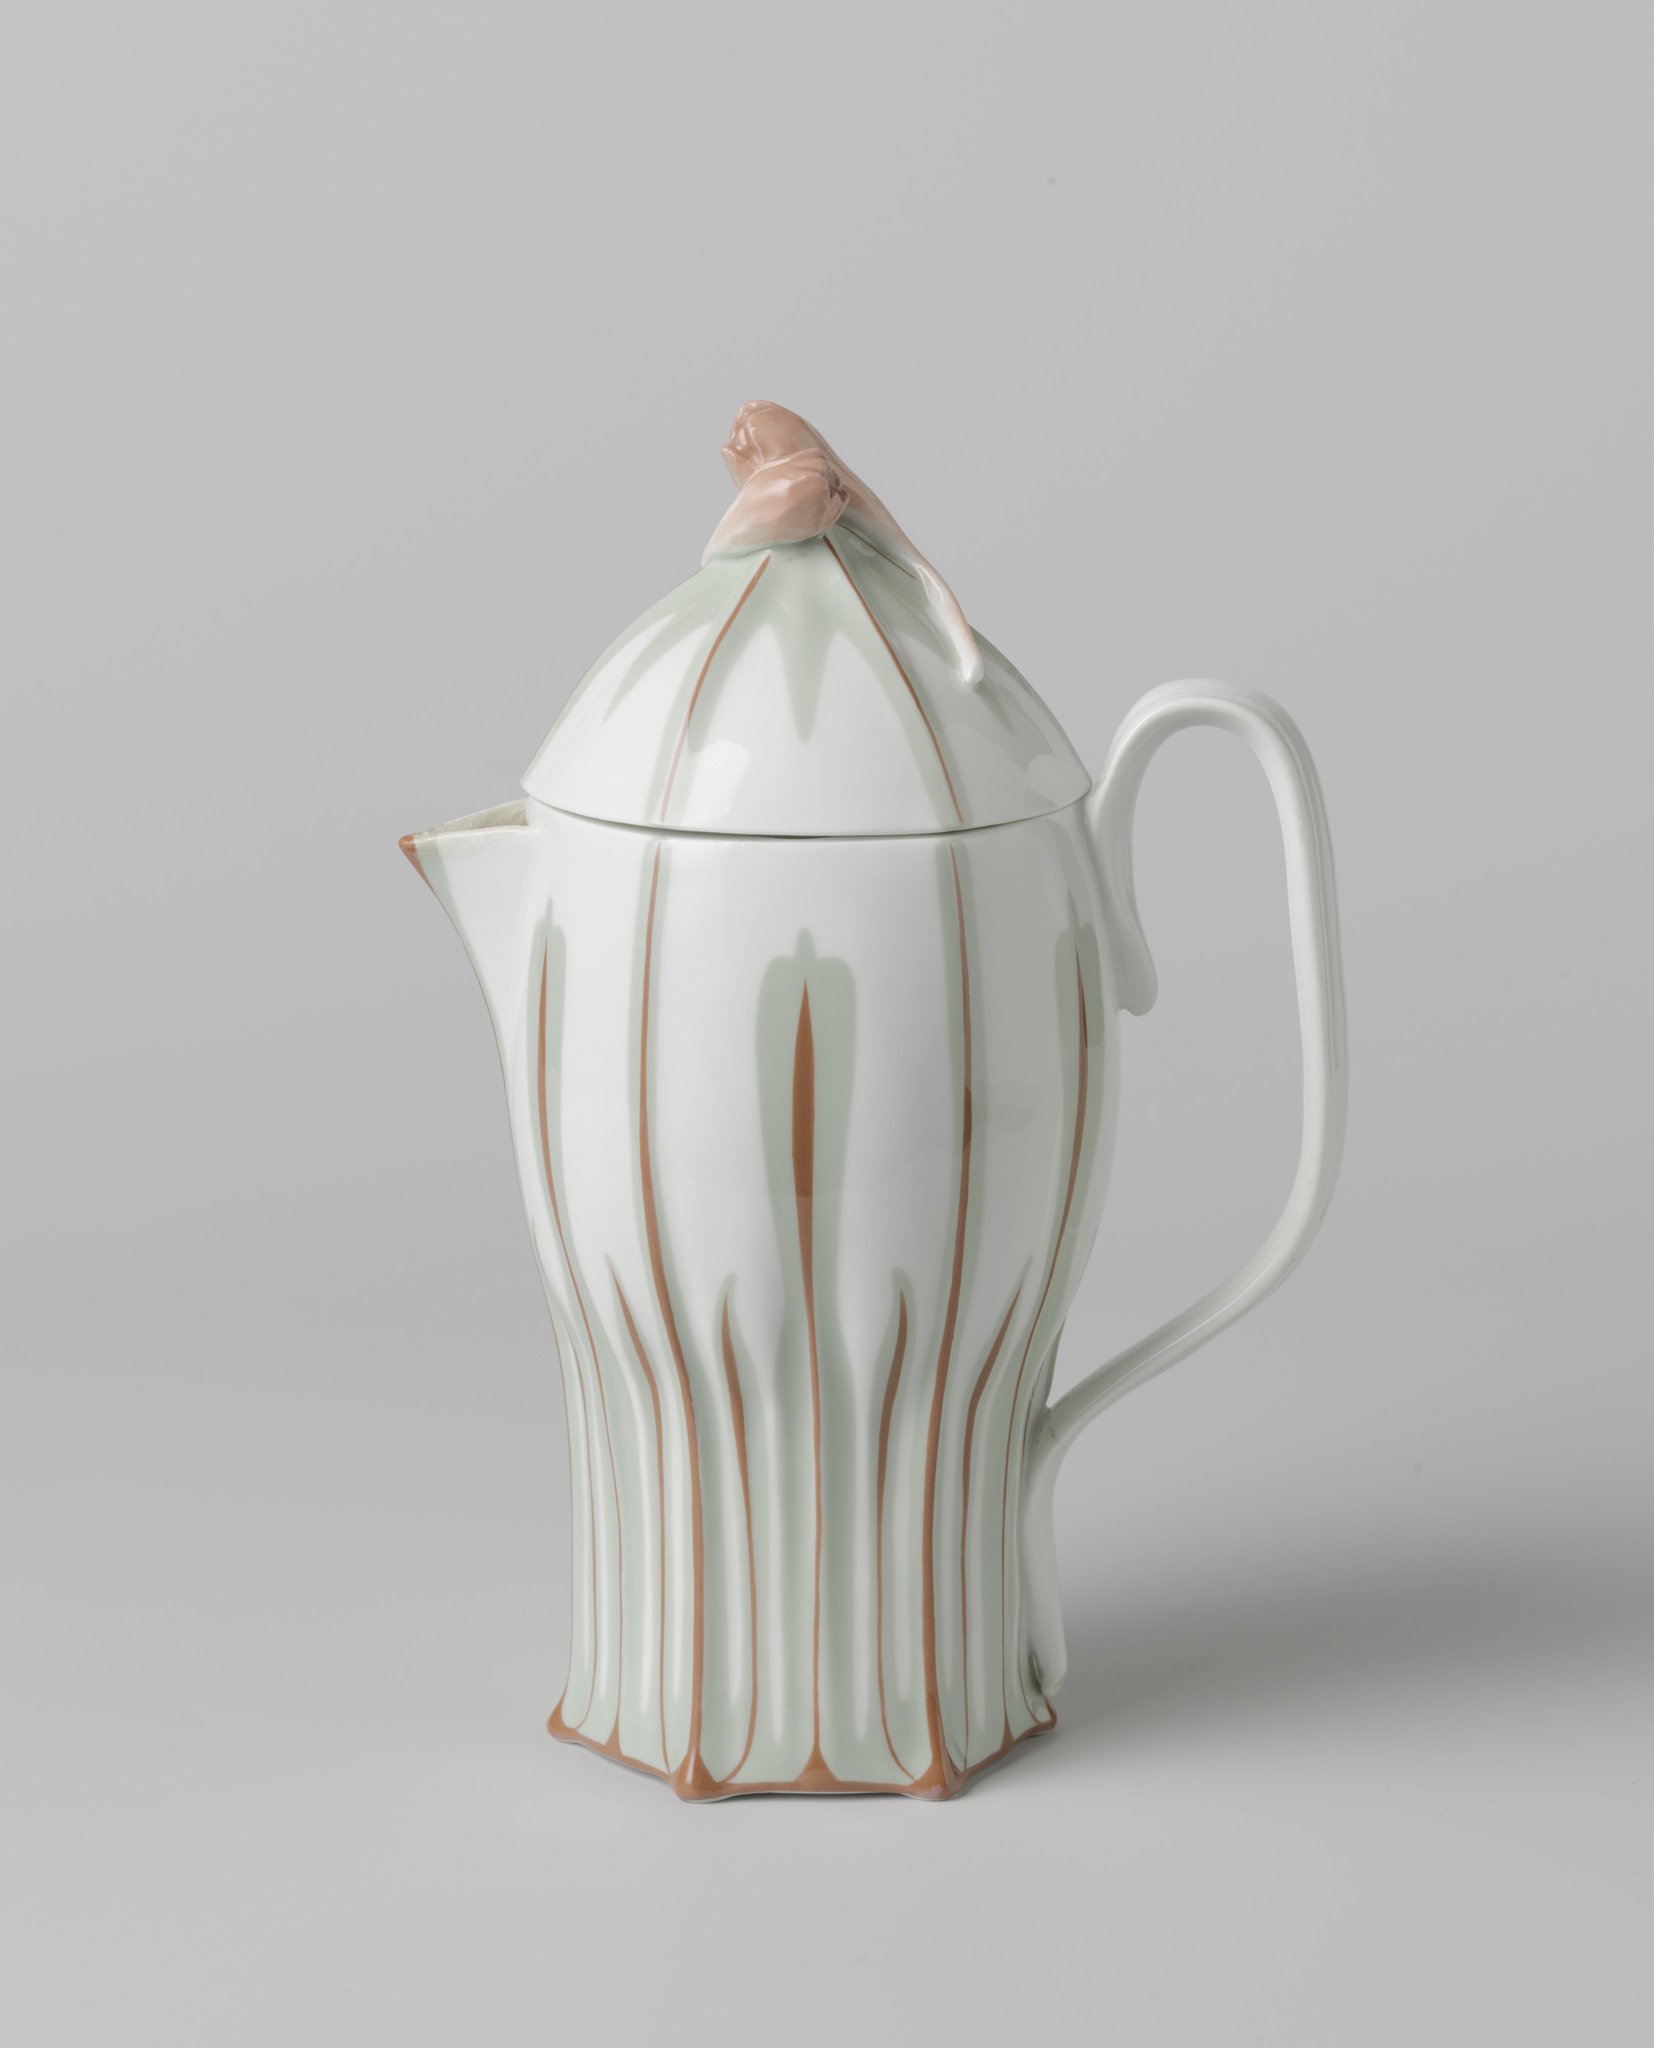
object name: eating drinking utensil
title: Koffiekan met deksel, beschilderd met het Krokus-decor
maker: konrad hentschel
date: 1896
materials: porcelain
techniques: painted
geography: meissen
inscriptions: model number: ‘Q108b’, factory mark, mark: ‘52’, mark: ‘87’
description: Koffiekan met deksel van beschilderd porselein. De kan heeft een deksel en is beschilderd in groen en bruin. De kan is gemerkt.